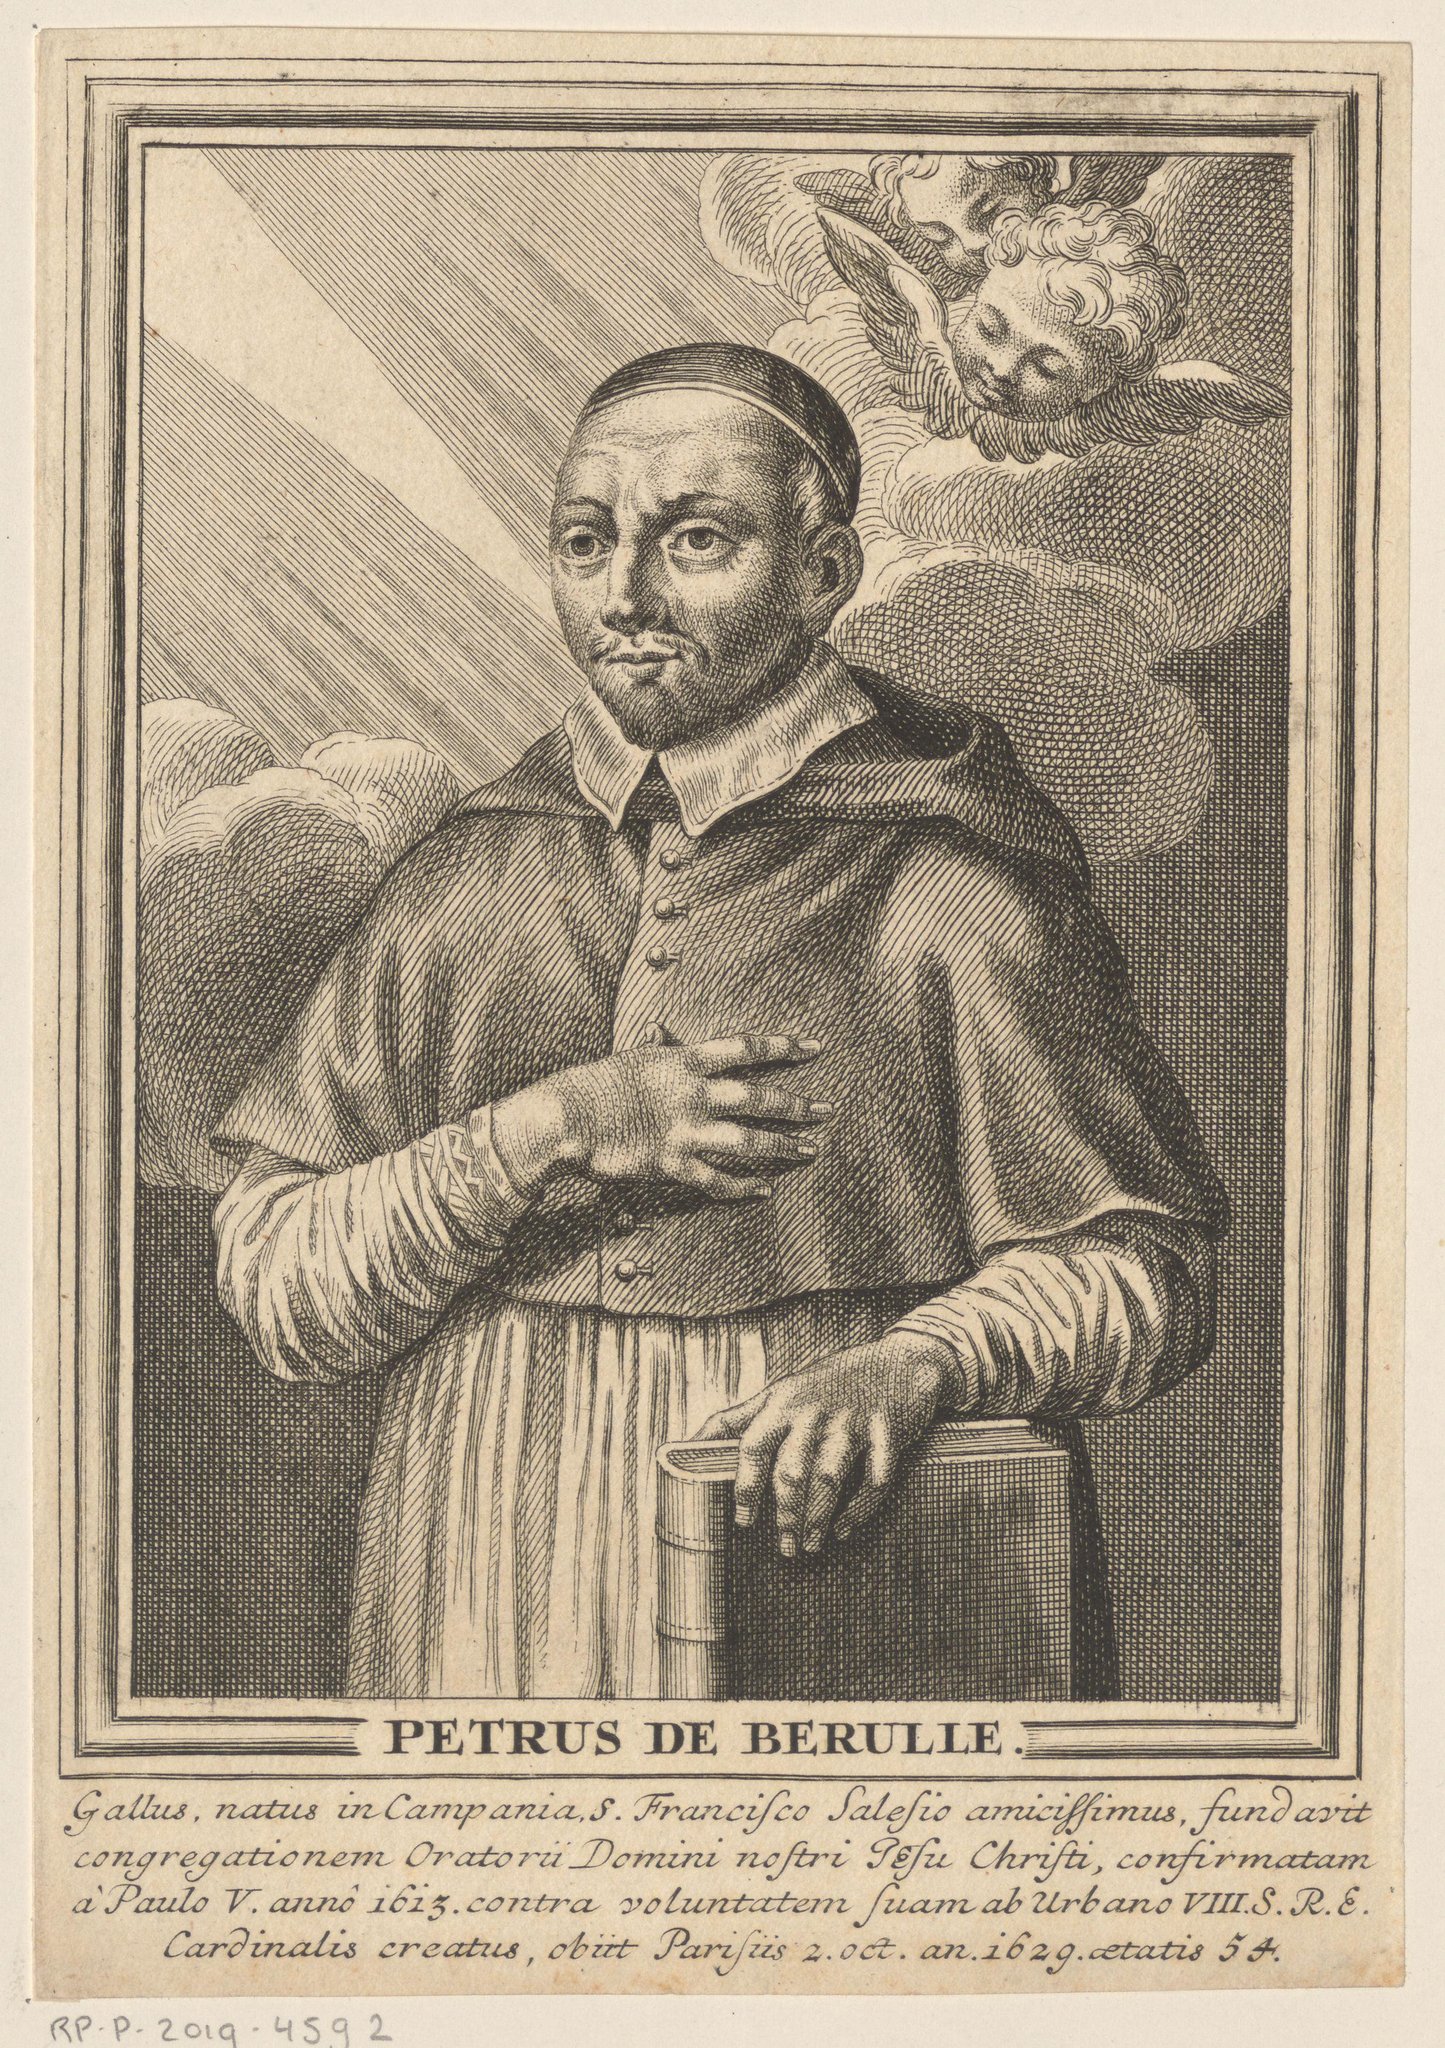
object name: print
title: Portret van Pierre de Bérulle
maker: Anonymous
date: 1700-1799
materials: paper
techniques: engraving, etching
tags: cherubs, i.e. children's heads with wings, cardinal, historical persons, book